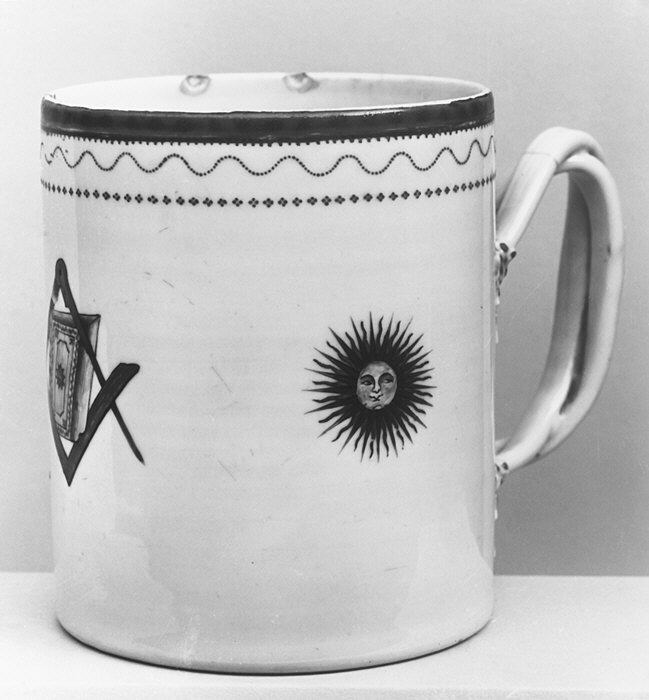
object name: mug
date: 1790-1810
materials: hard paste porcelain